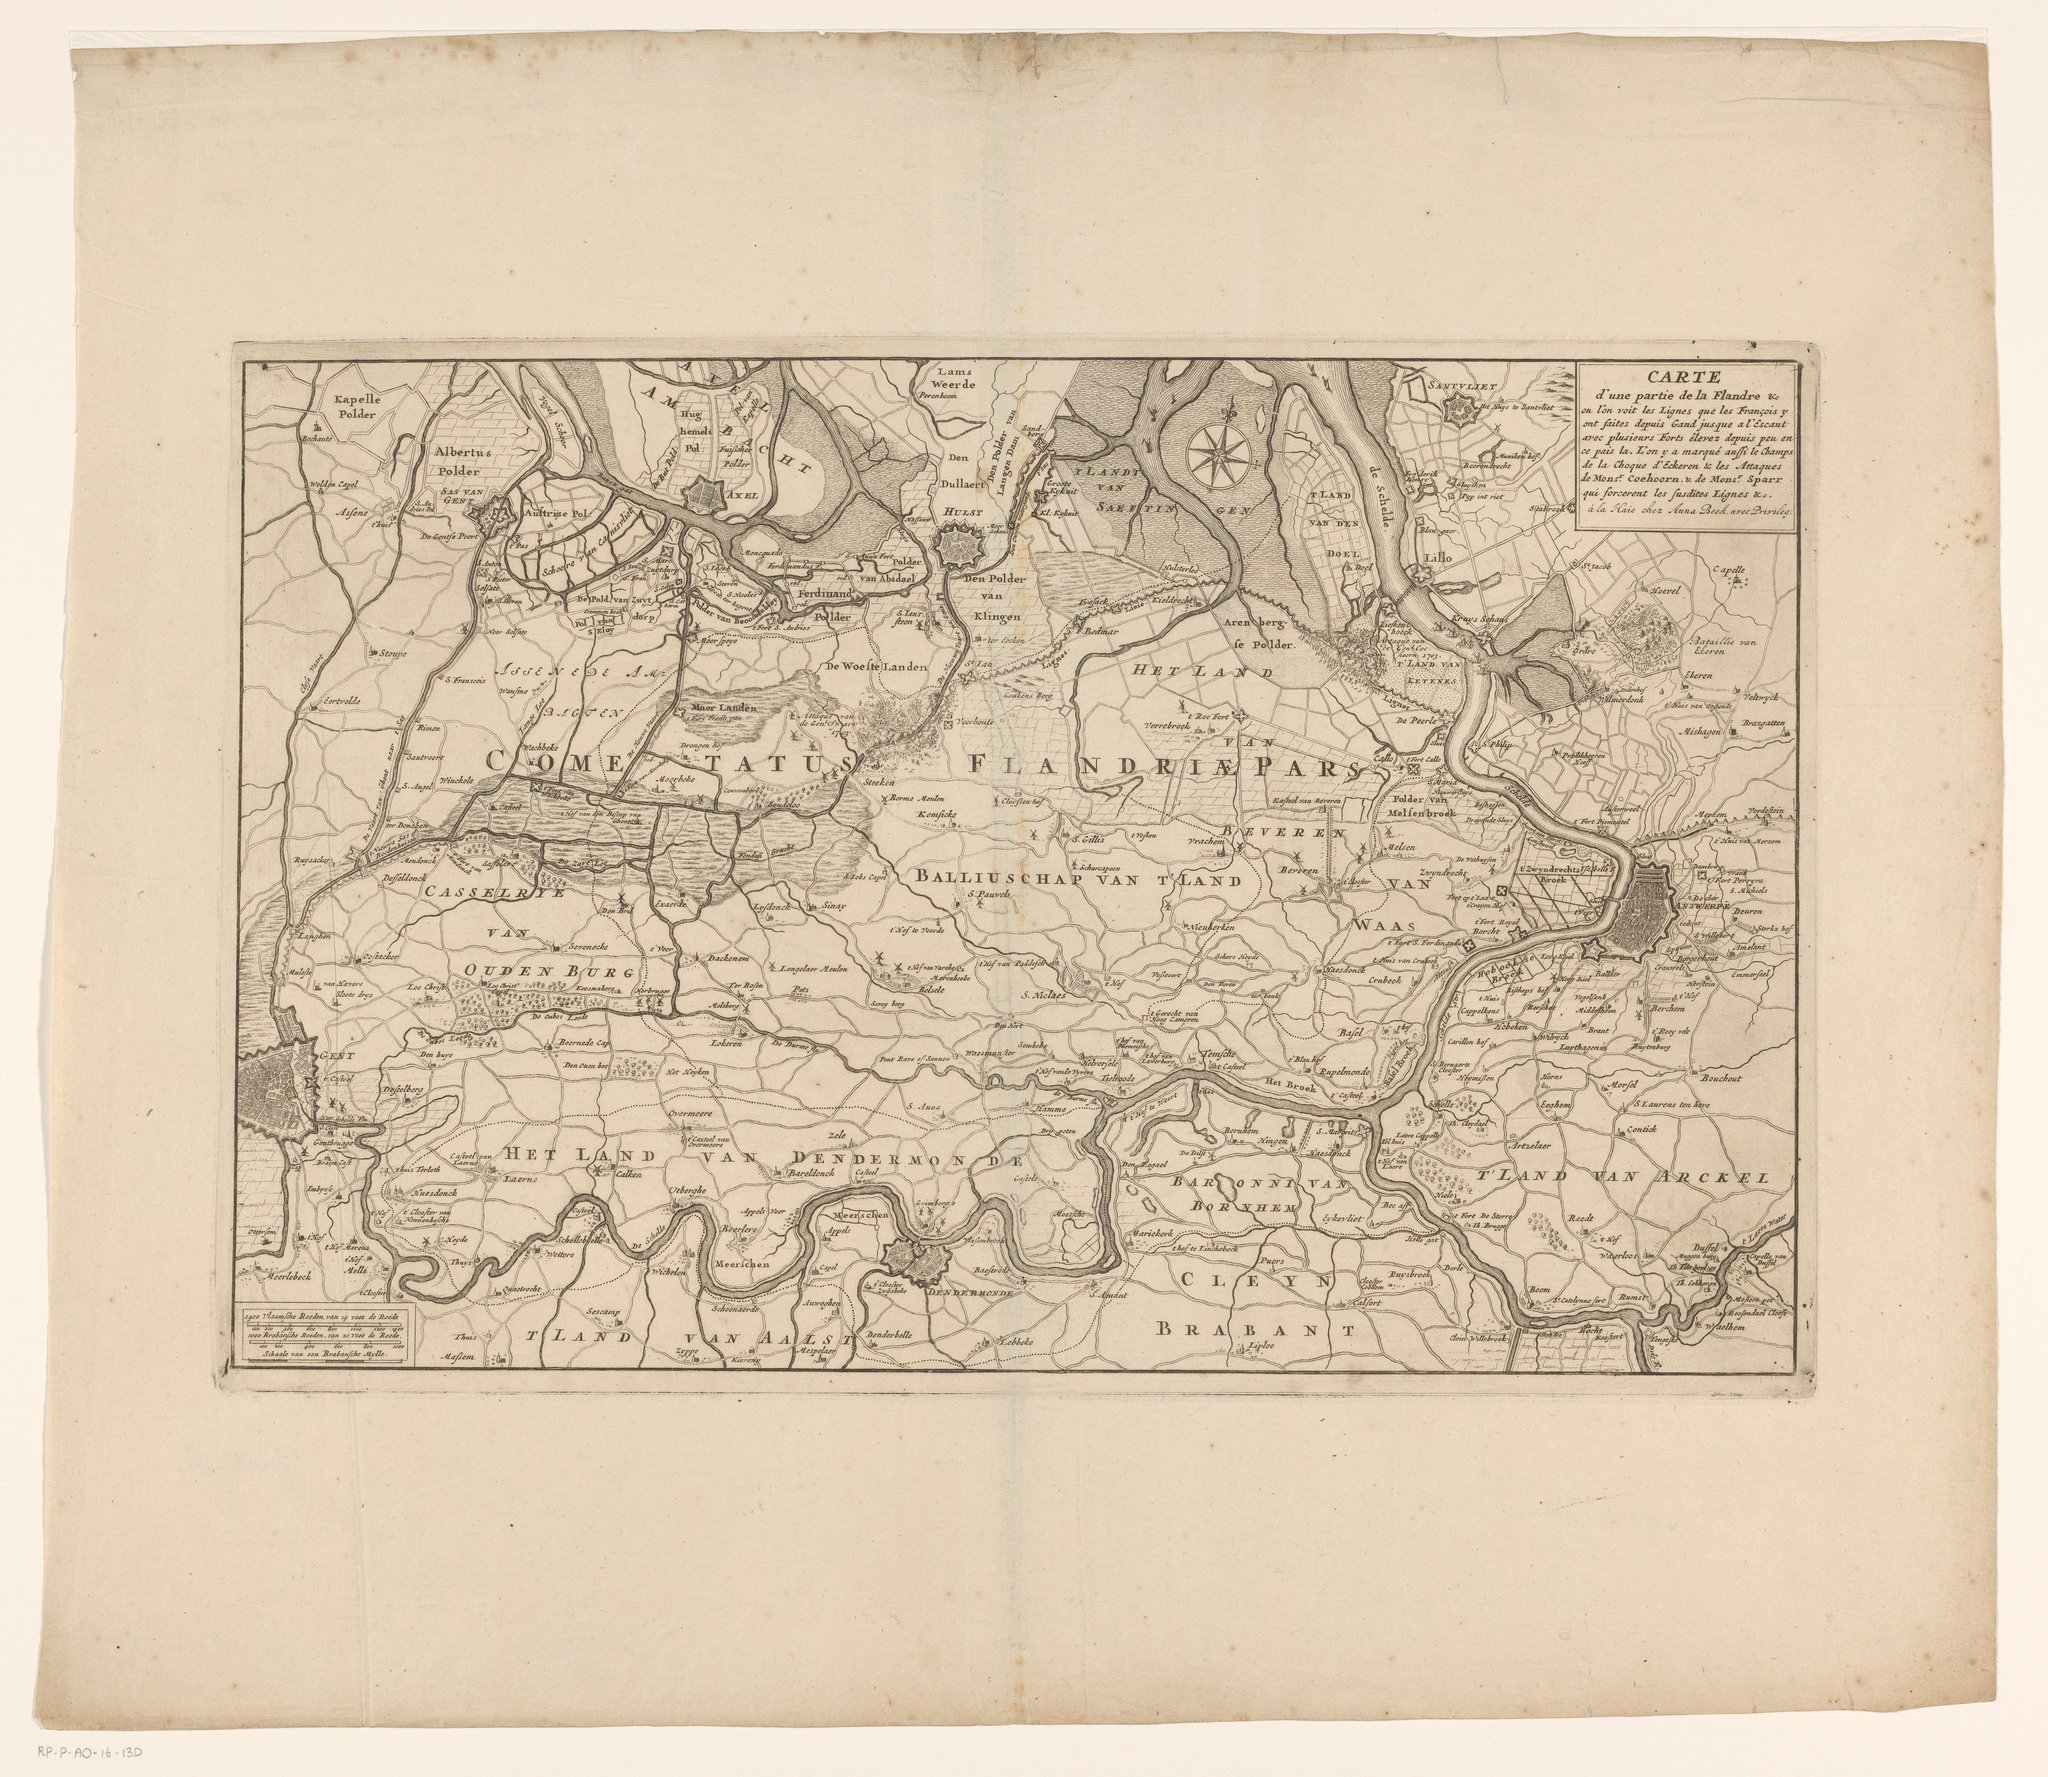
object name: map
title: Kaart van Oost-Vlaanderen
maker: jan van call (i)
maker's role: draughtsman, print maker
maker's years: 1656-1706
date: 1703-1717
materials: paper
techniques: engraving, etching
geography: northern netherlands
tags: maps of separate countries or regions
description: Kaart van Oost-Vlaanderen waarop verschillende verdedigingslinies uit de Spaanse Successieoorlog zijn aangegeven. Rechtsboven een cartouche met titel. Linksonder drie schaalstokken: 1400 Vlaamsche Roeden, van 14 voet de Roede / 1000 Brabantsche Roeden, van 20 Voet de Roede / Schaale van een Brabantsche Mylle.